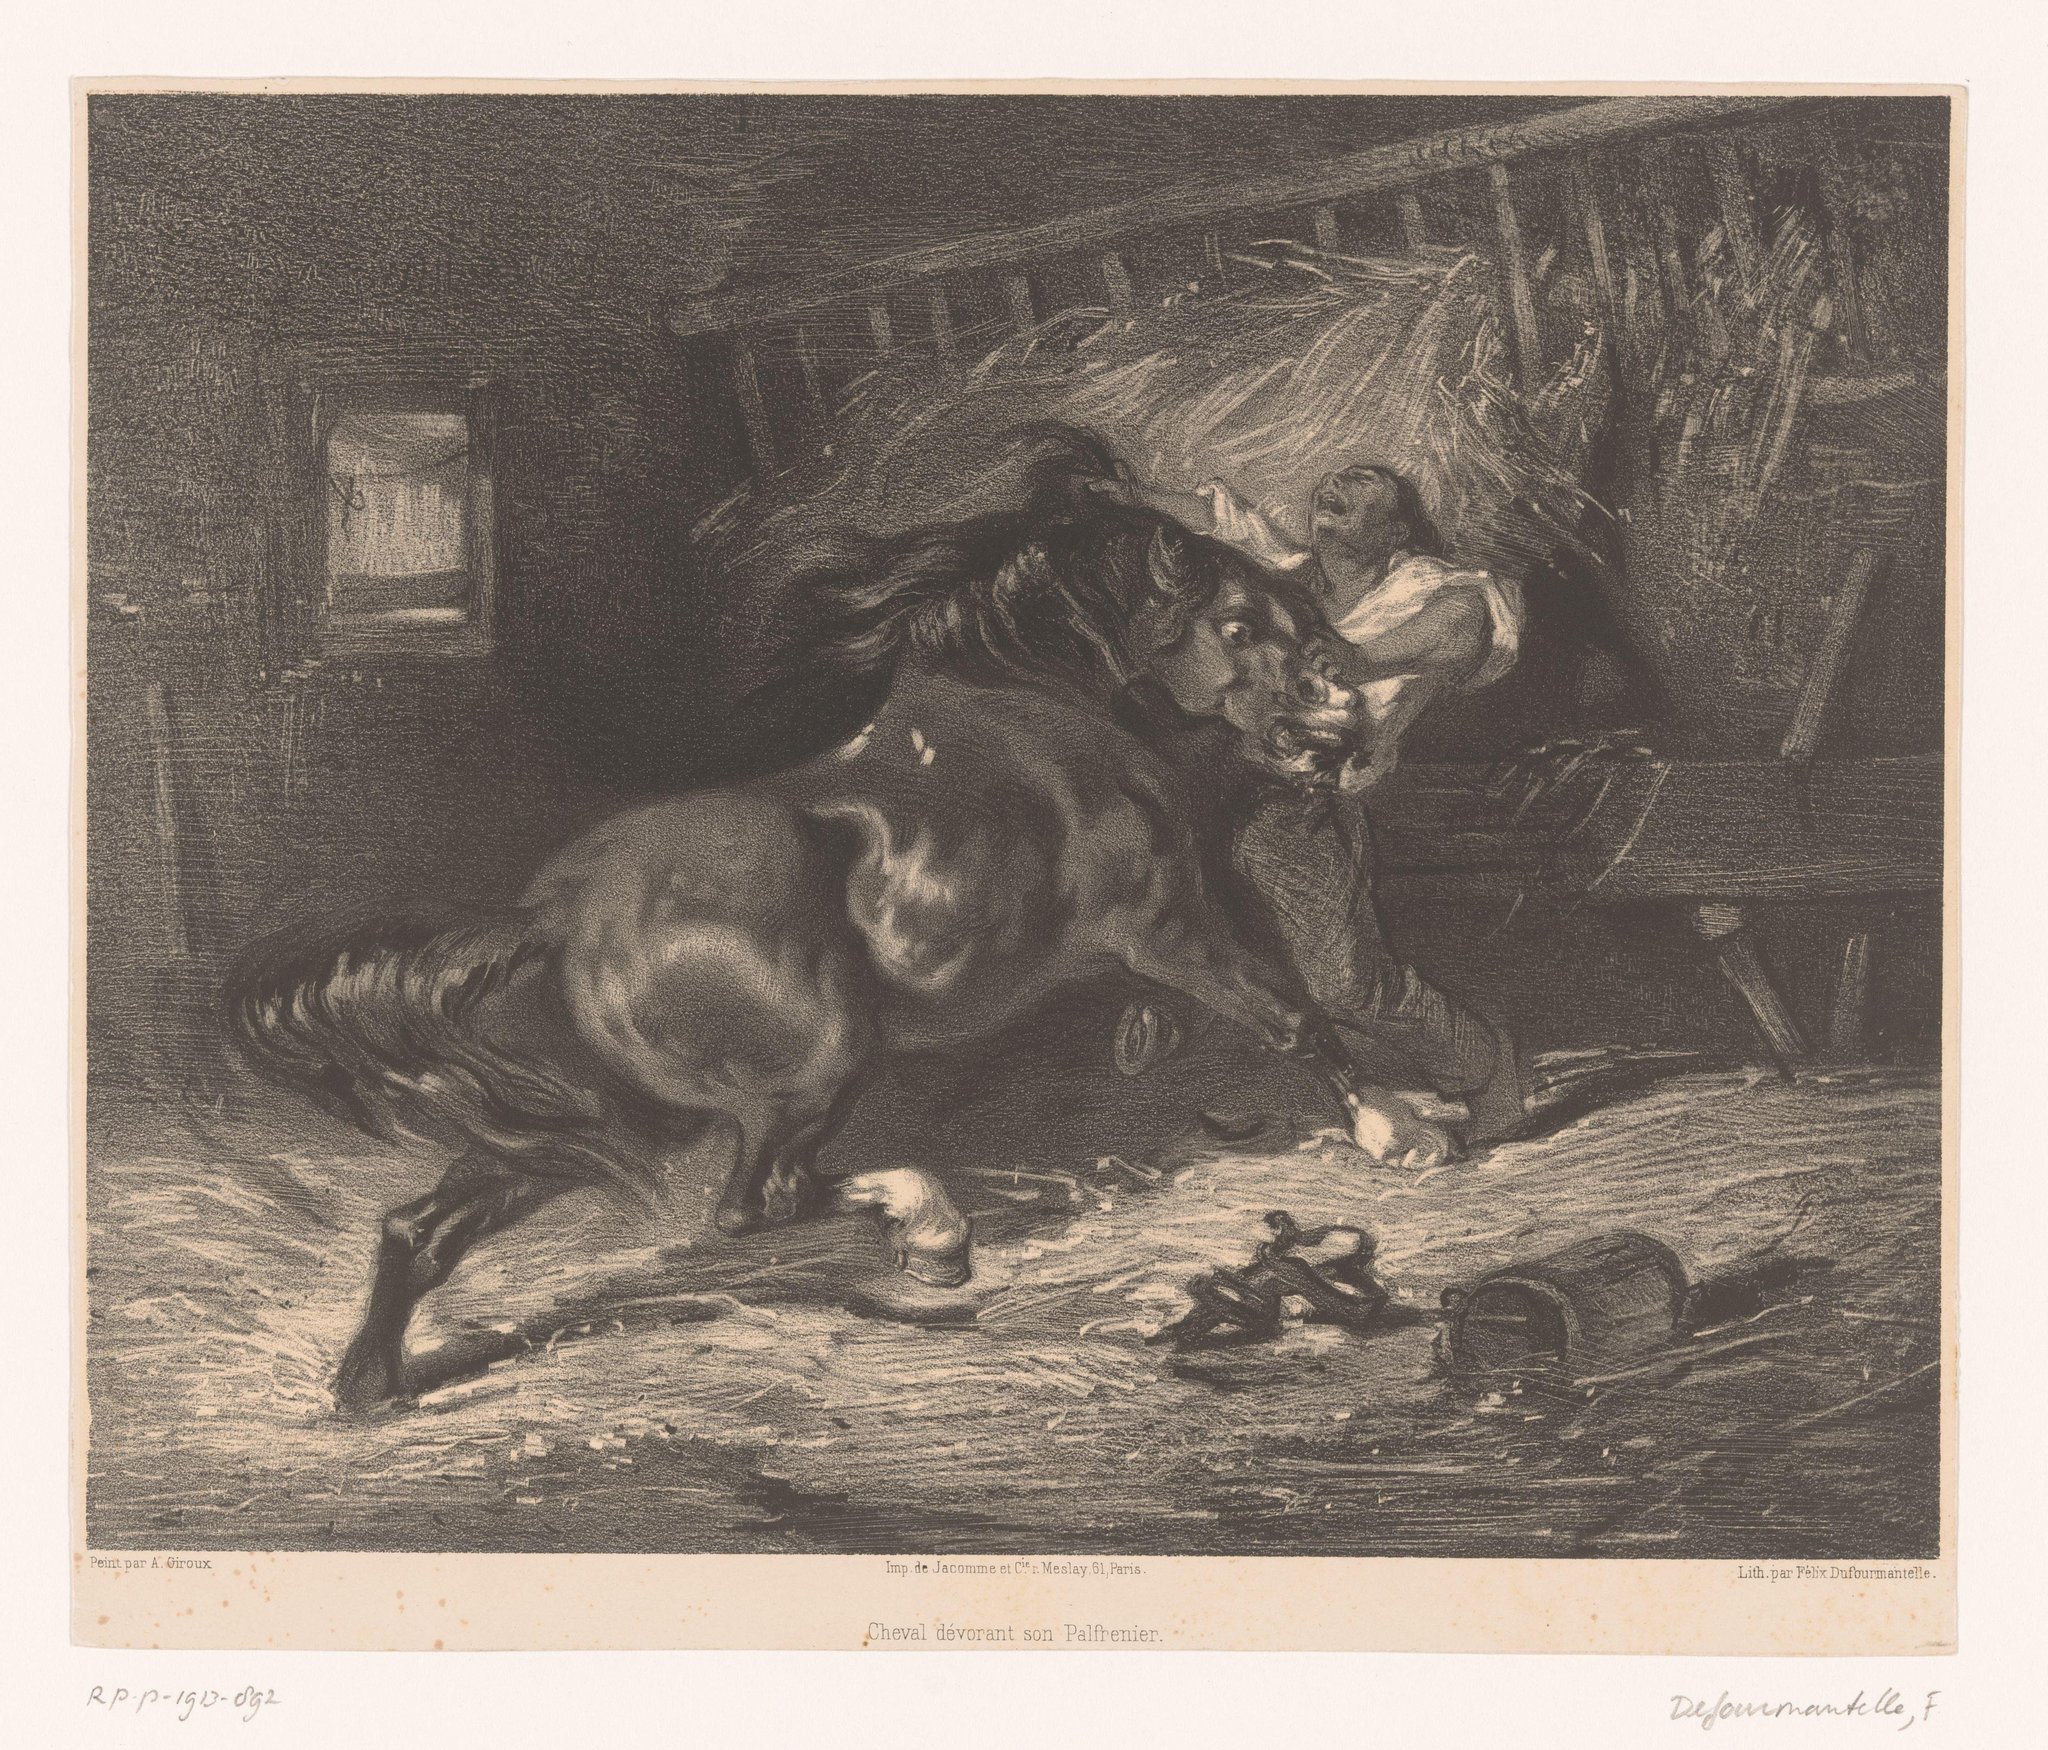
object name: print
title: Cheval dévorant son Palfrenier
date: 1853-1859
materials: paper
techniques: lithograph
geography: paris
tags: animals threatening man, horse, accident with horse (or kindred animal), groom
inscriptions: collector's mark: Lugt 2228a